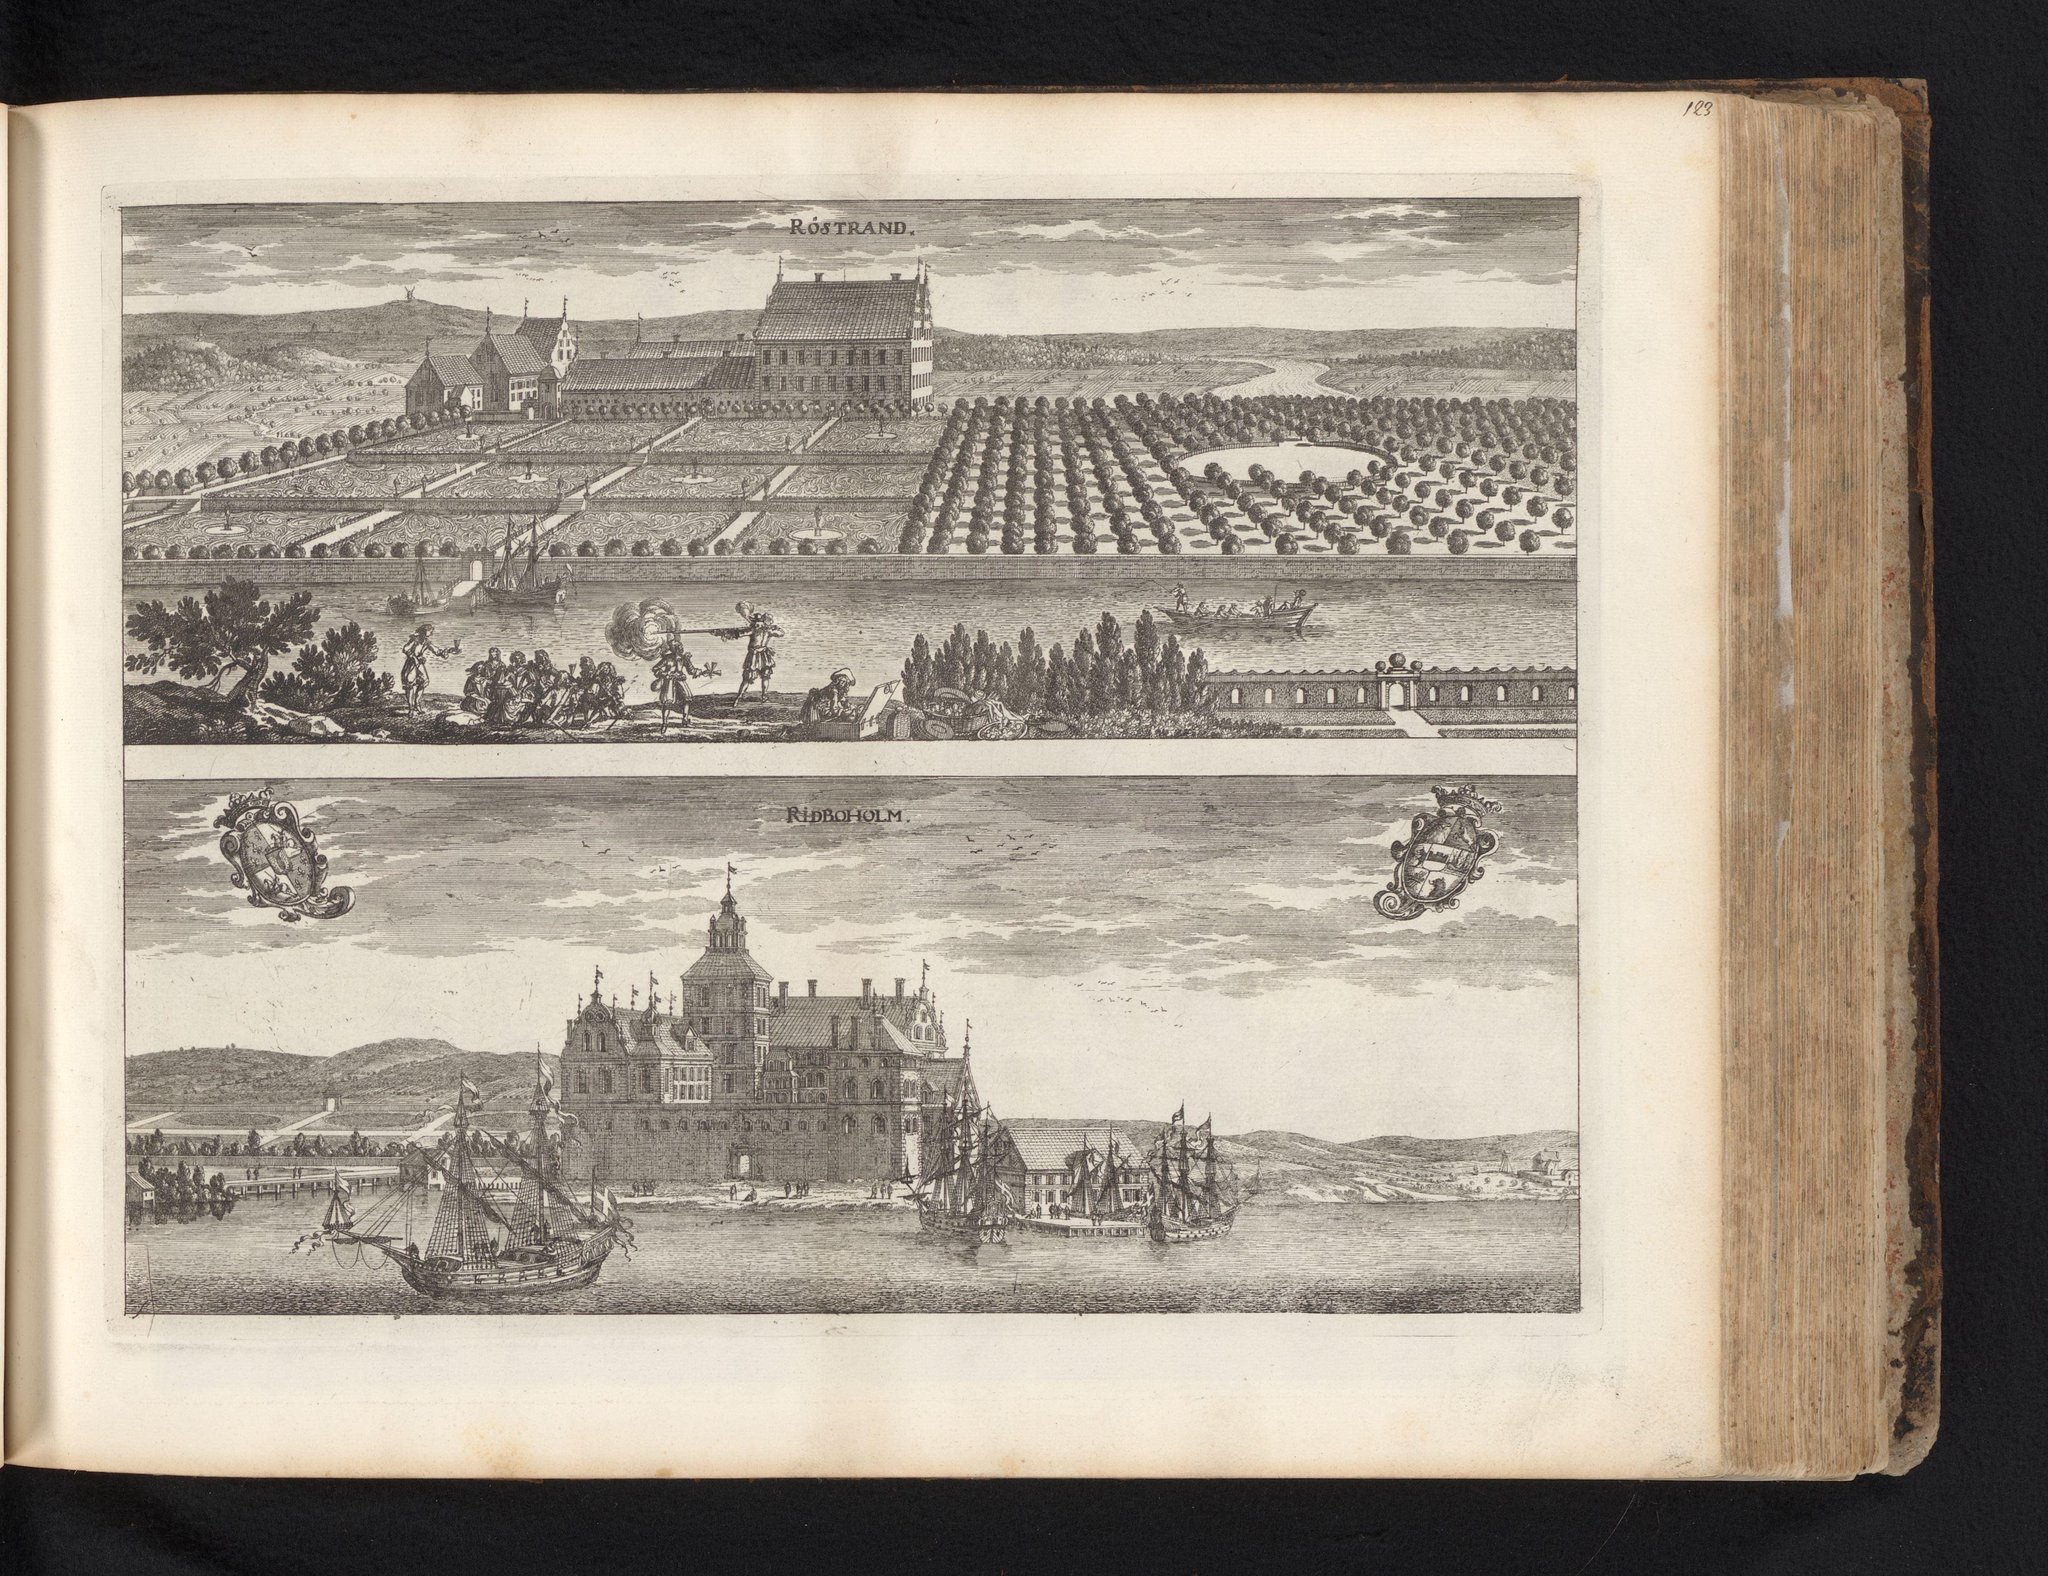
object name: album leaf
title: Suecia Antiqua et Hodierna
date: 1670-1674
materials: paper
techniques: etching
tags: housing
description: Kungliga Biblioteket, 'Suecia': http://www.kb.se/samlingarna/Kartor-bilder/Suecia-antiqua/ (geraadpleegd november 2016).